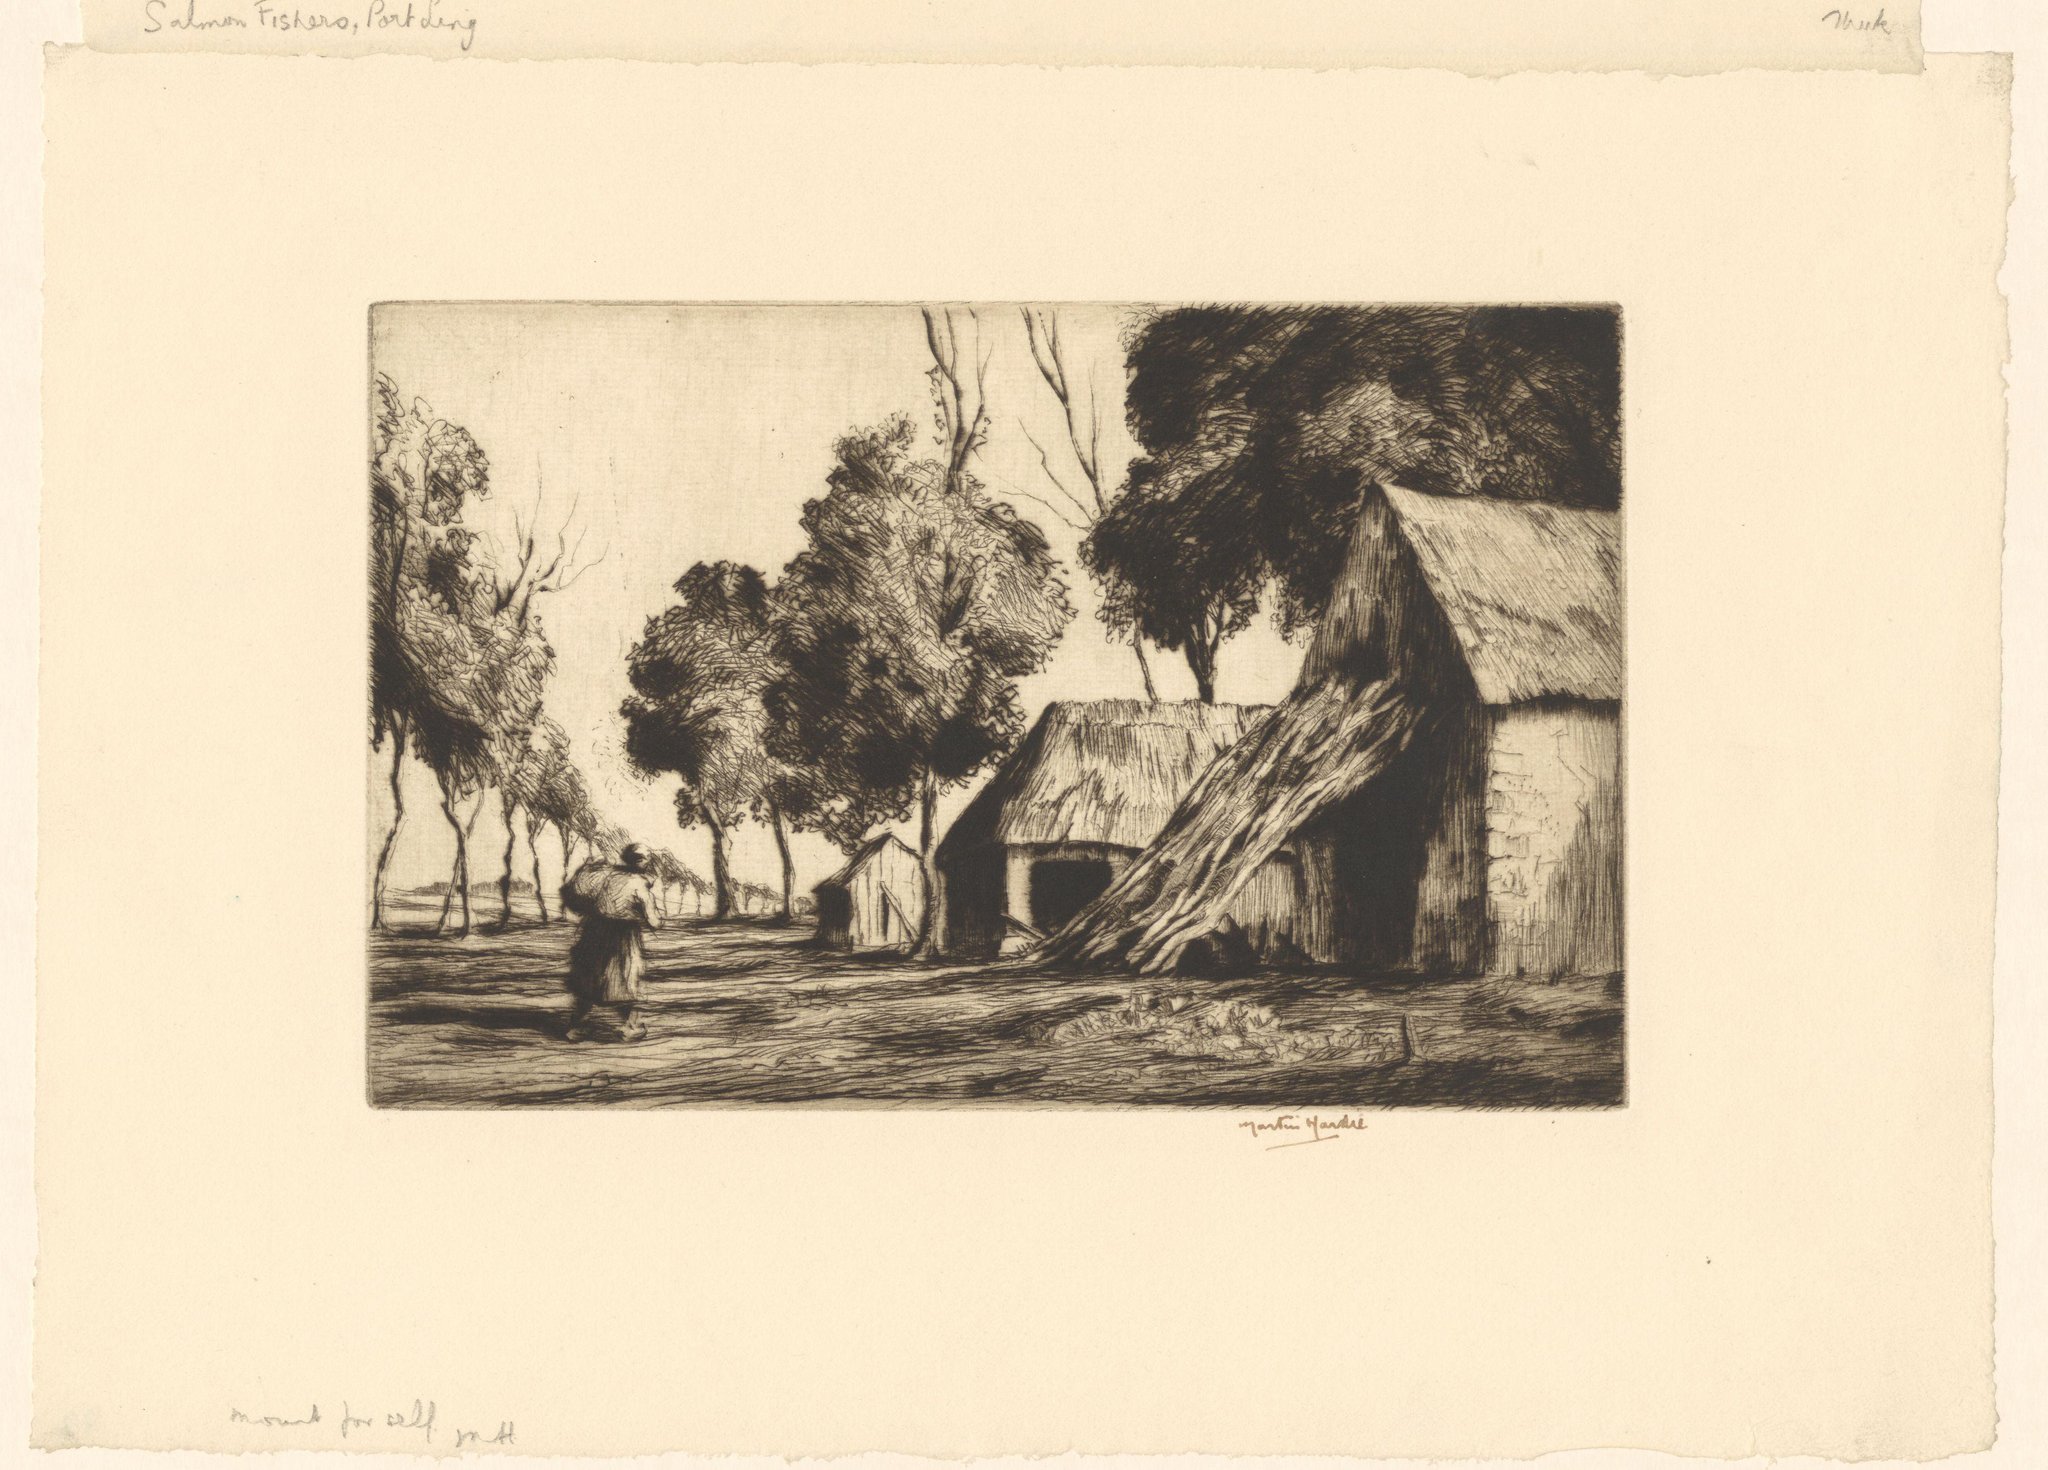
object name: print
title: Boerderij bij Port Manec'h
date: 1920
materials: paper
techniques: drypoint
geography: brittany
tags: farm (building)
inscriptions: collector's mark: Lugt 2760, collector's mark: Lugt 2228, annotation: ‘Martin Hardie’